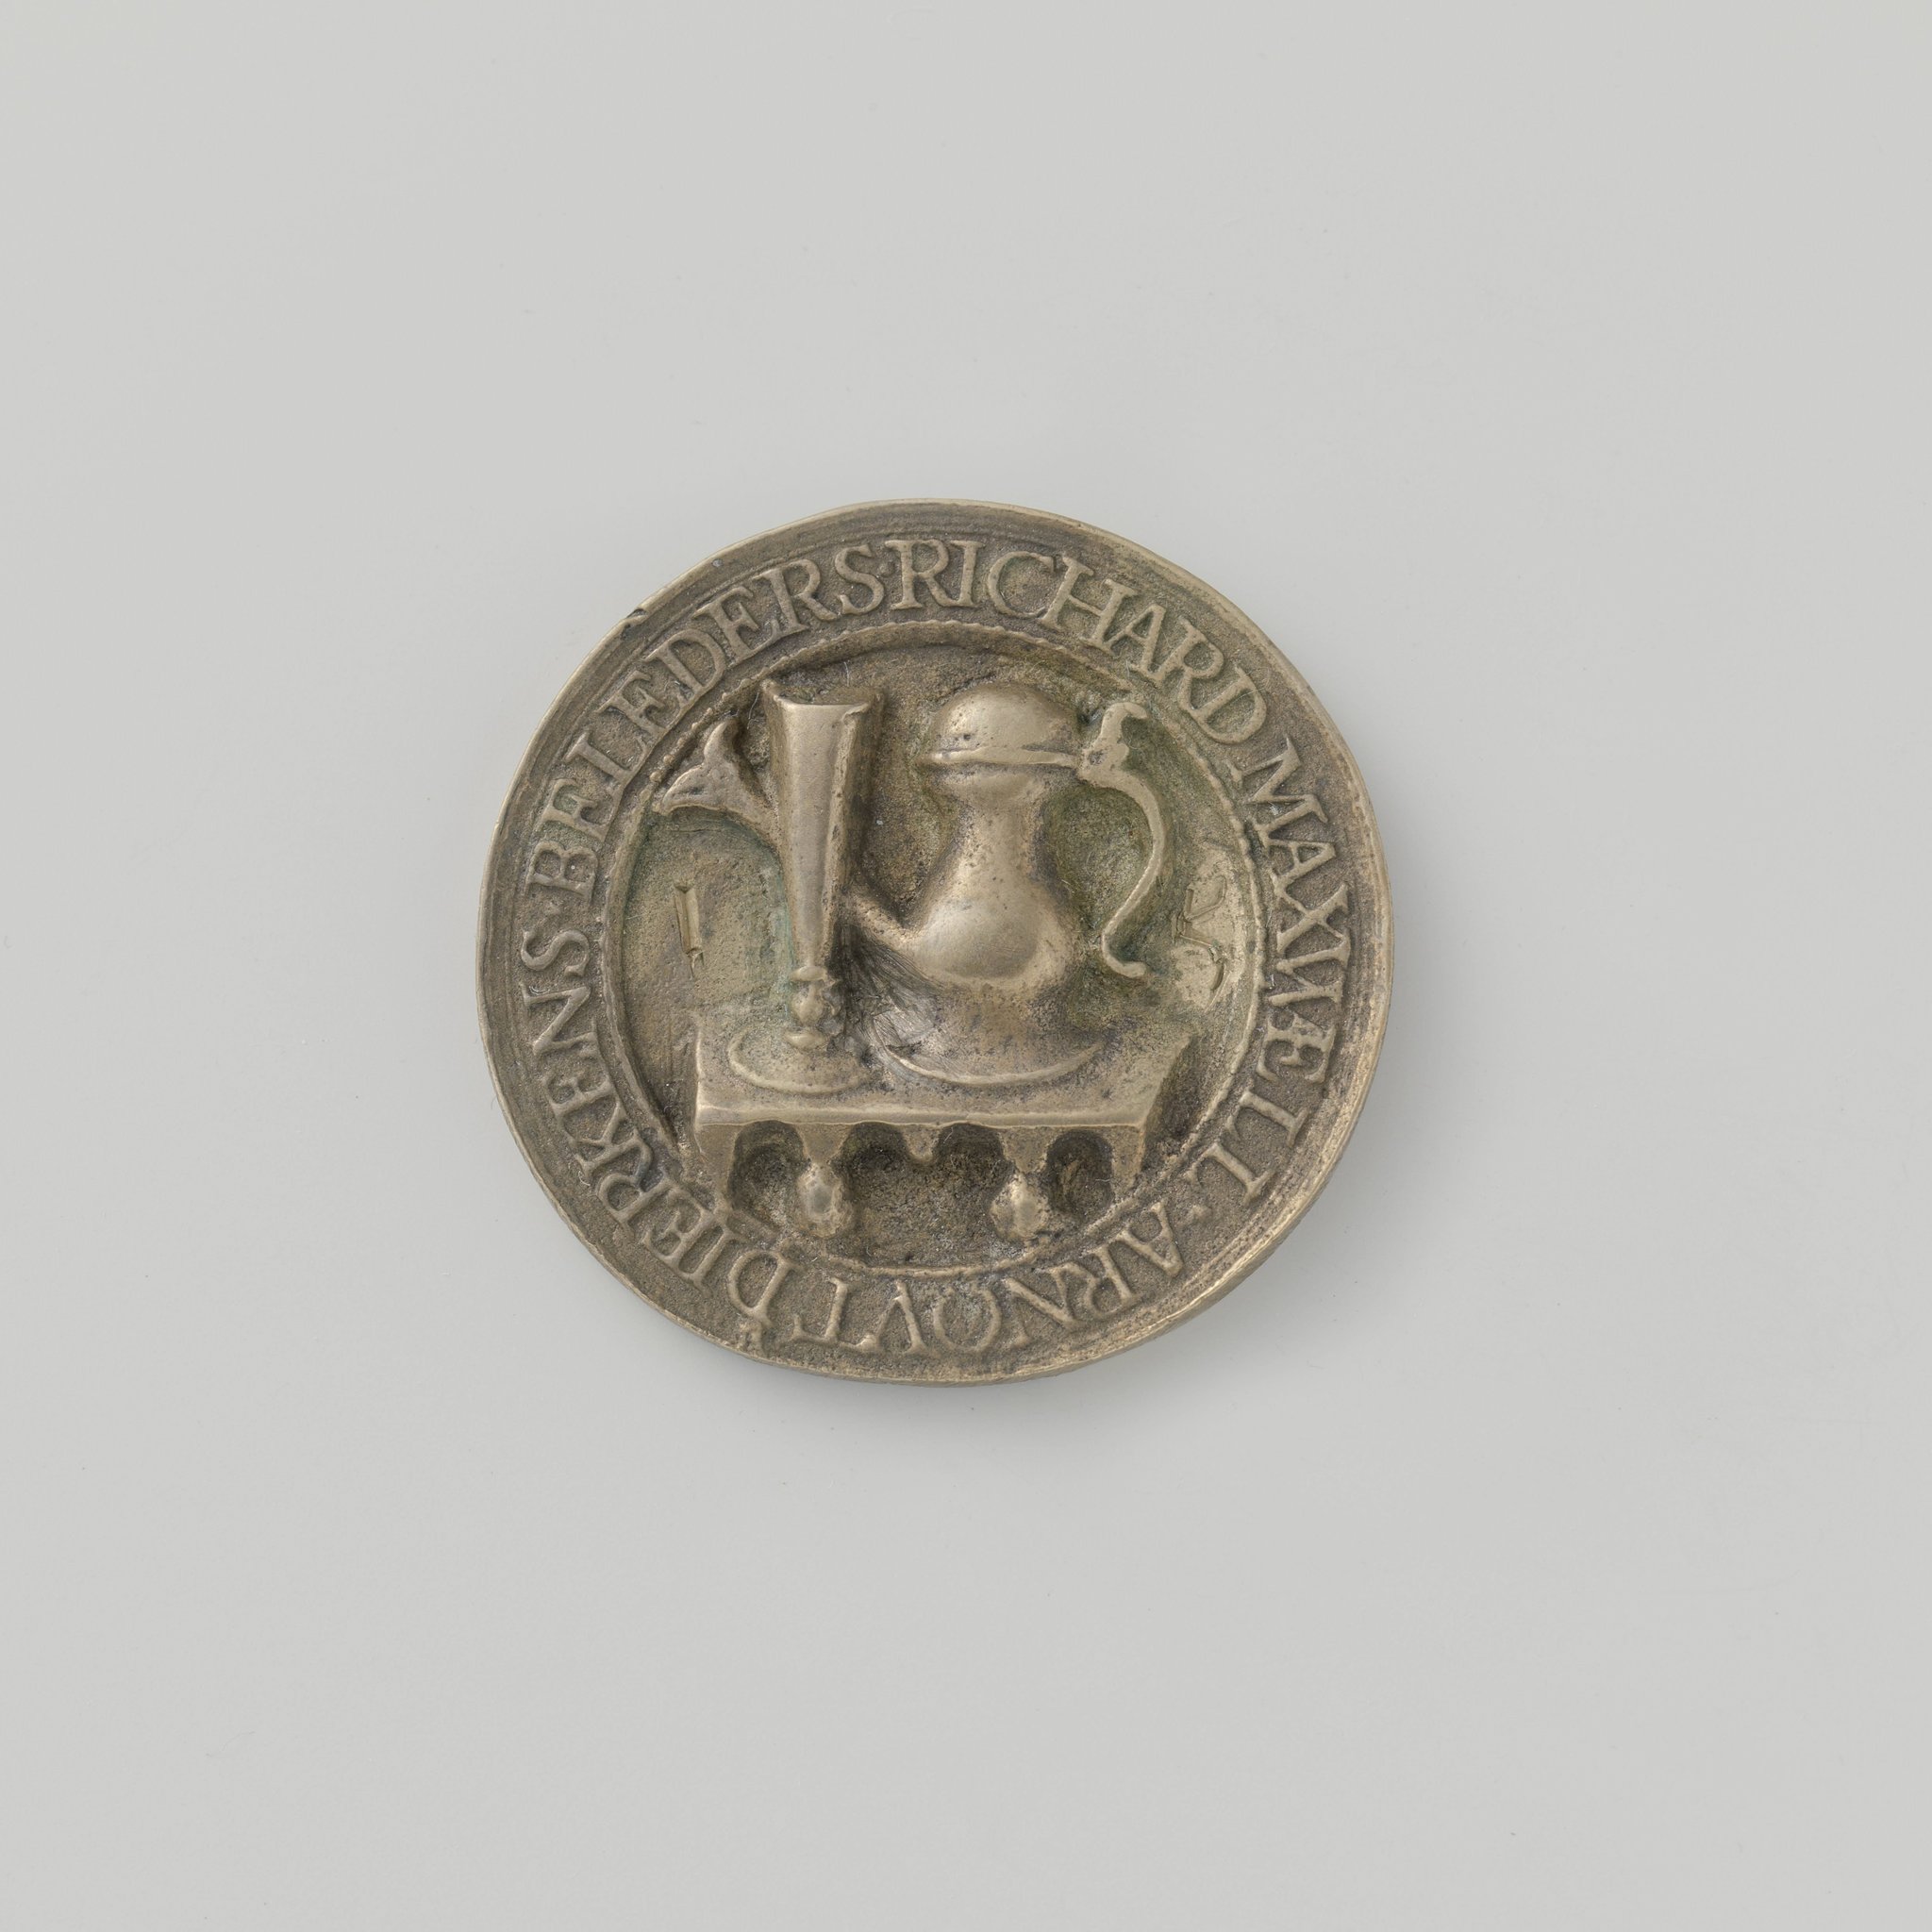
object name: medal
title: Wine and Beer Publicans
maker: Anonymous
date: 1634-1651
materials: brass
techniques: casting, engraving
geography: middelburg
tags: hendrick thibaut, middelburg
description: Guild medals Members of trade guilds had to identify themselves with a medal at their meetings.